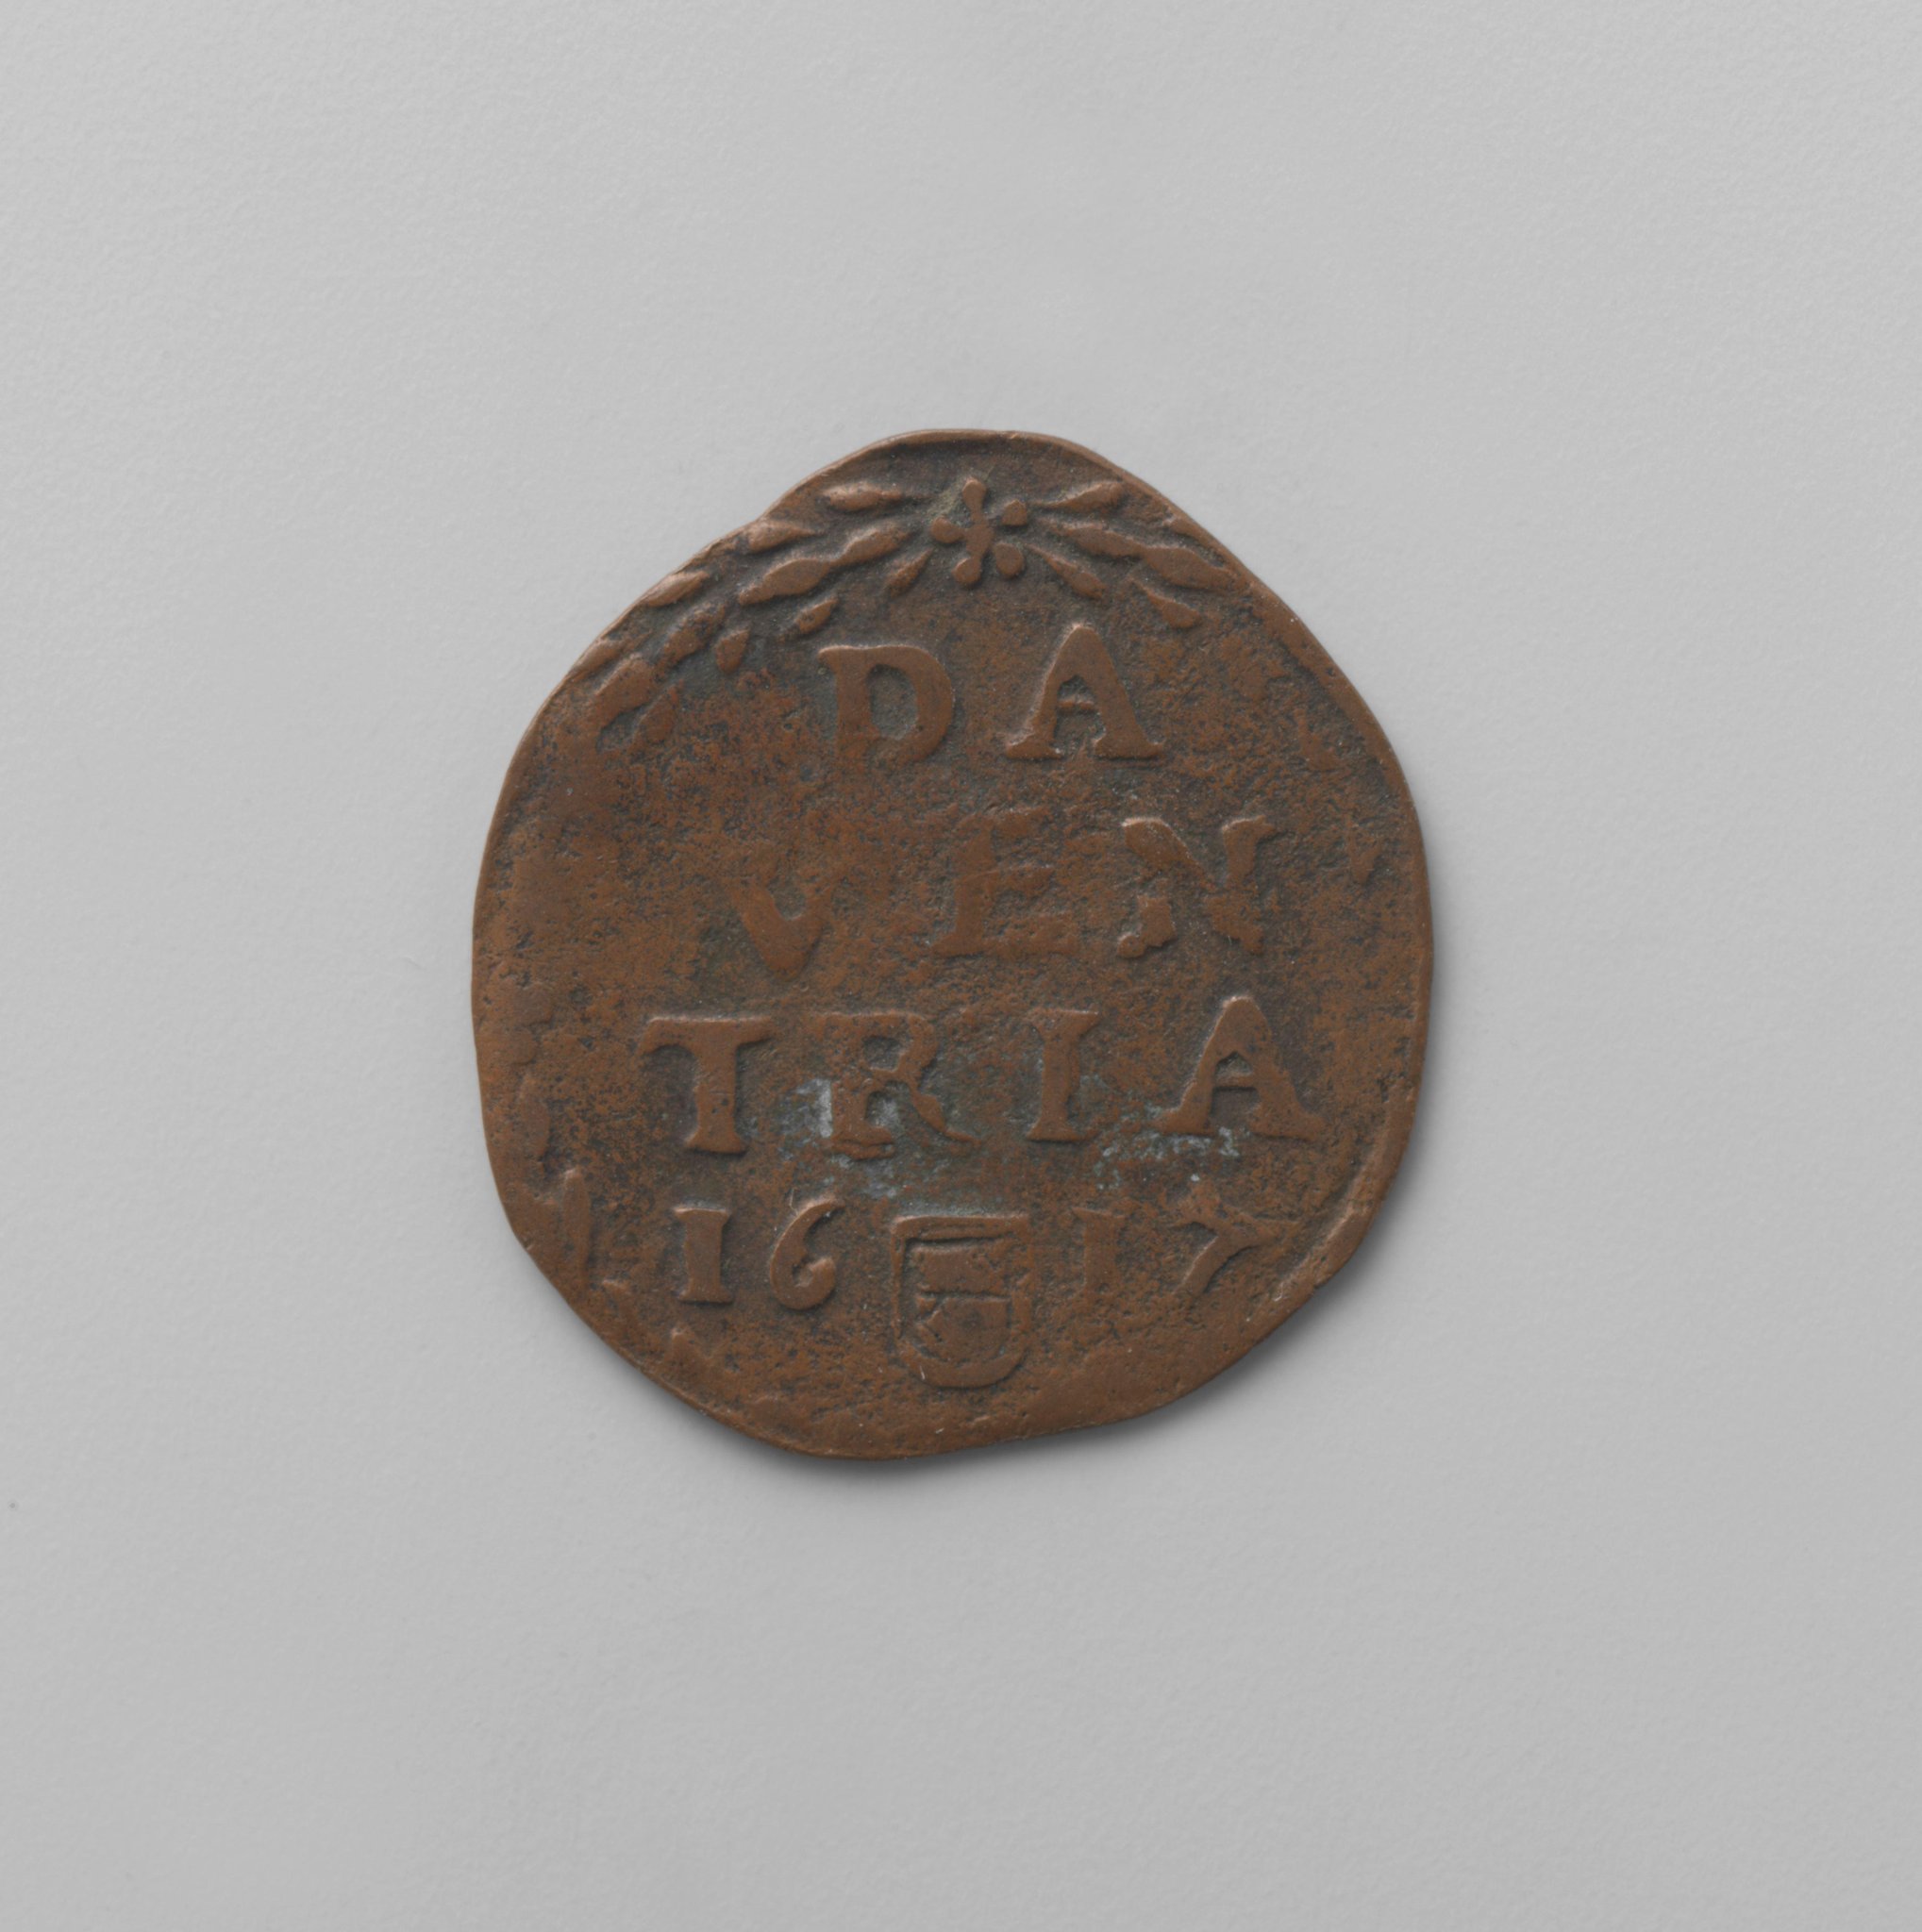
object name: coin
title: Duit van Deventer, 1617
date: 1617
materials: copper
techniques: striking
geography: deventer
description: Koperen munt. Voorzijde: gekroond wapenschild van Deventer op lang versierd kruis. Keerzijde: binnen een bladerkrans drieregelig opschrift, waaronder wapenschild tussen jaartal.